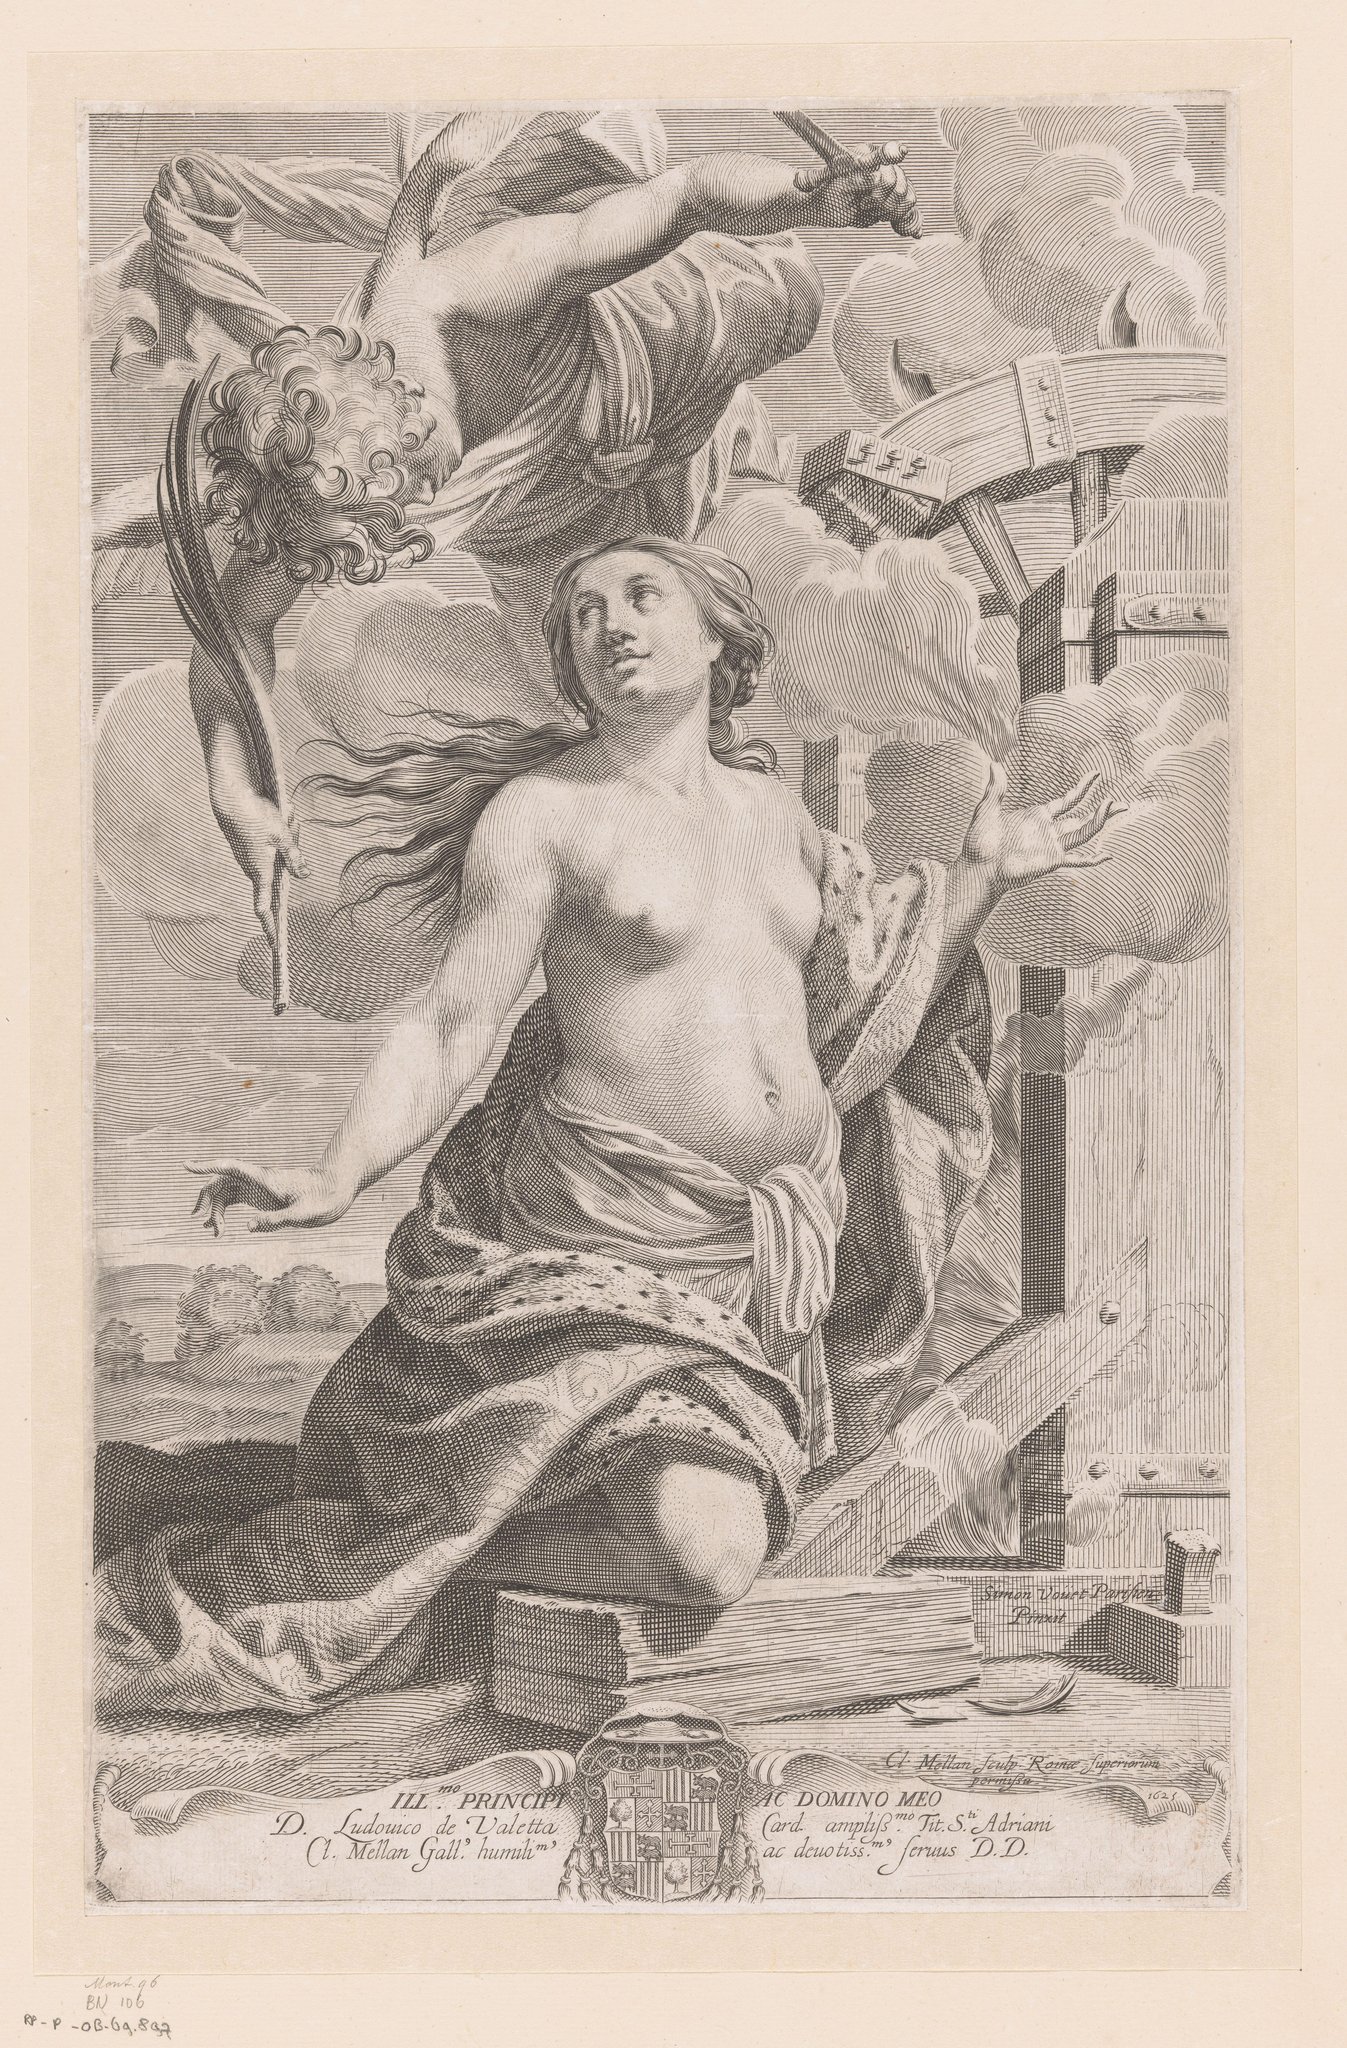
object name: print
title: Heilige Catherina van Alexandrië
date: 1625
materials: paper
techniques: engraving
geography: rome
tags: the virgin martyr catherine of alexandria; possible attributes: book, crown, emperor maxentius, palm-branch, ring, sword, wheel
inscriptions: collector's mark: Lugt 240